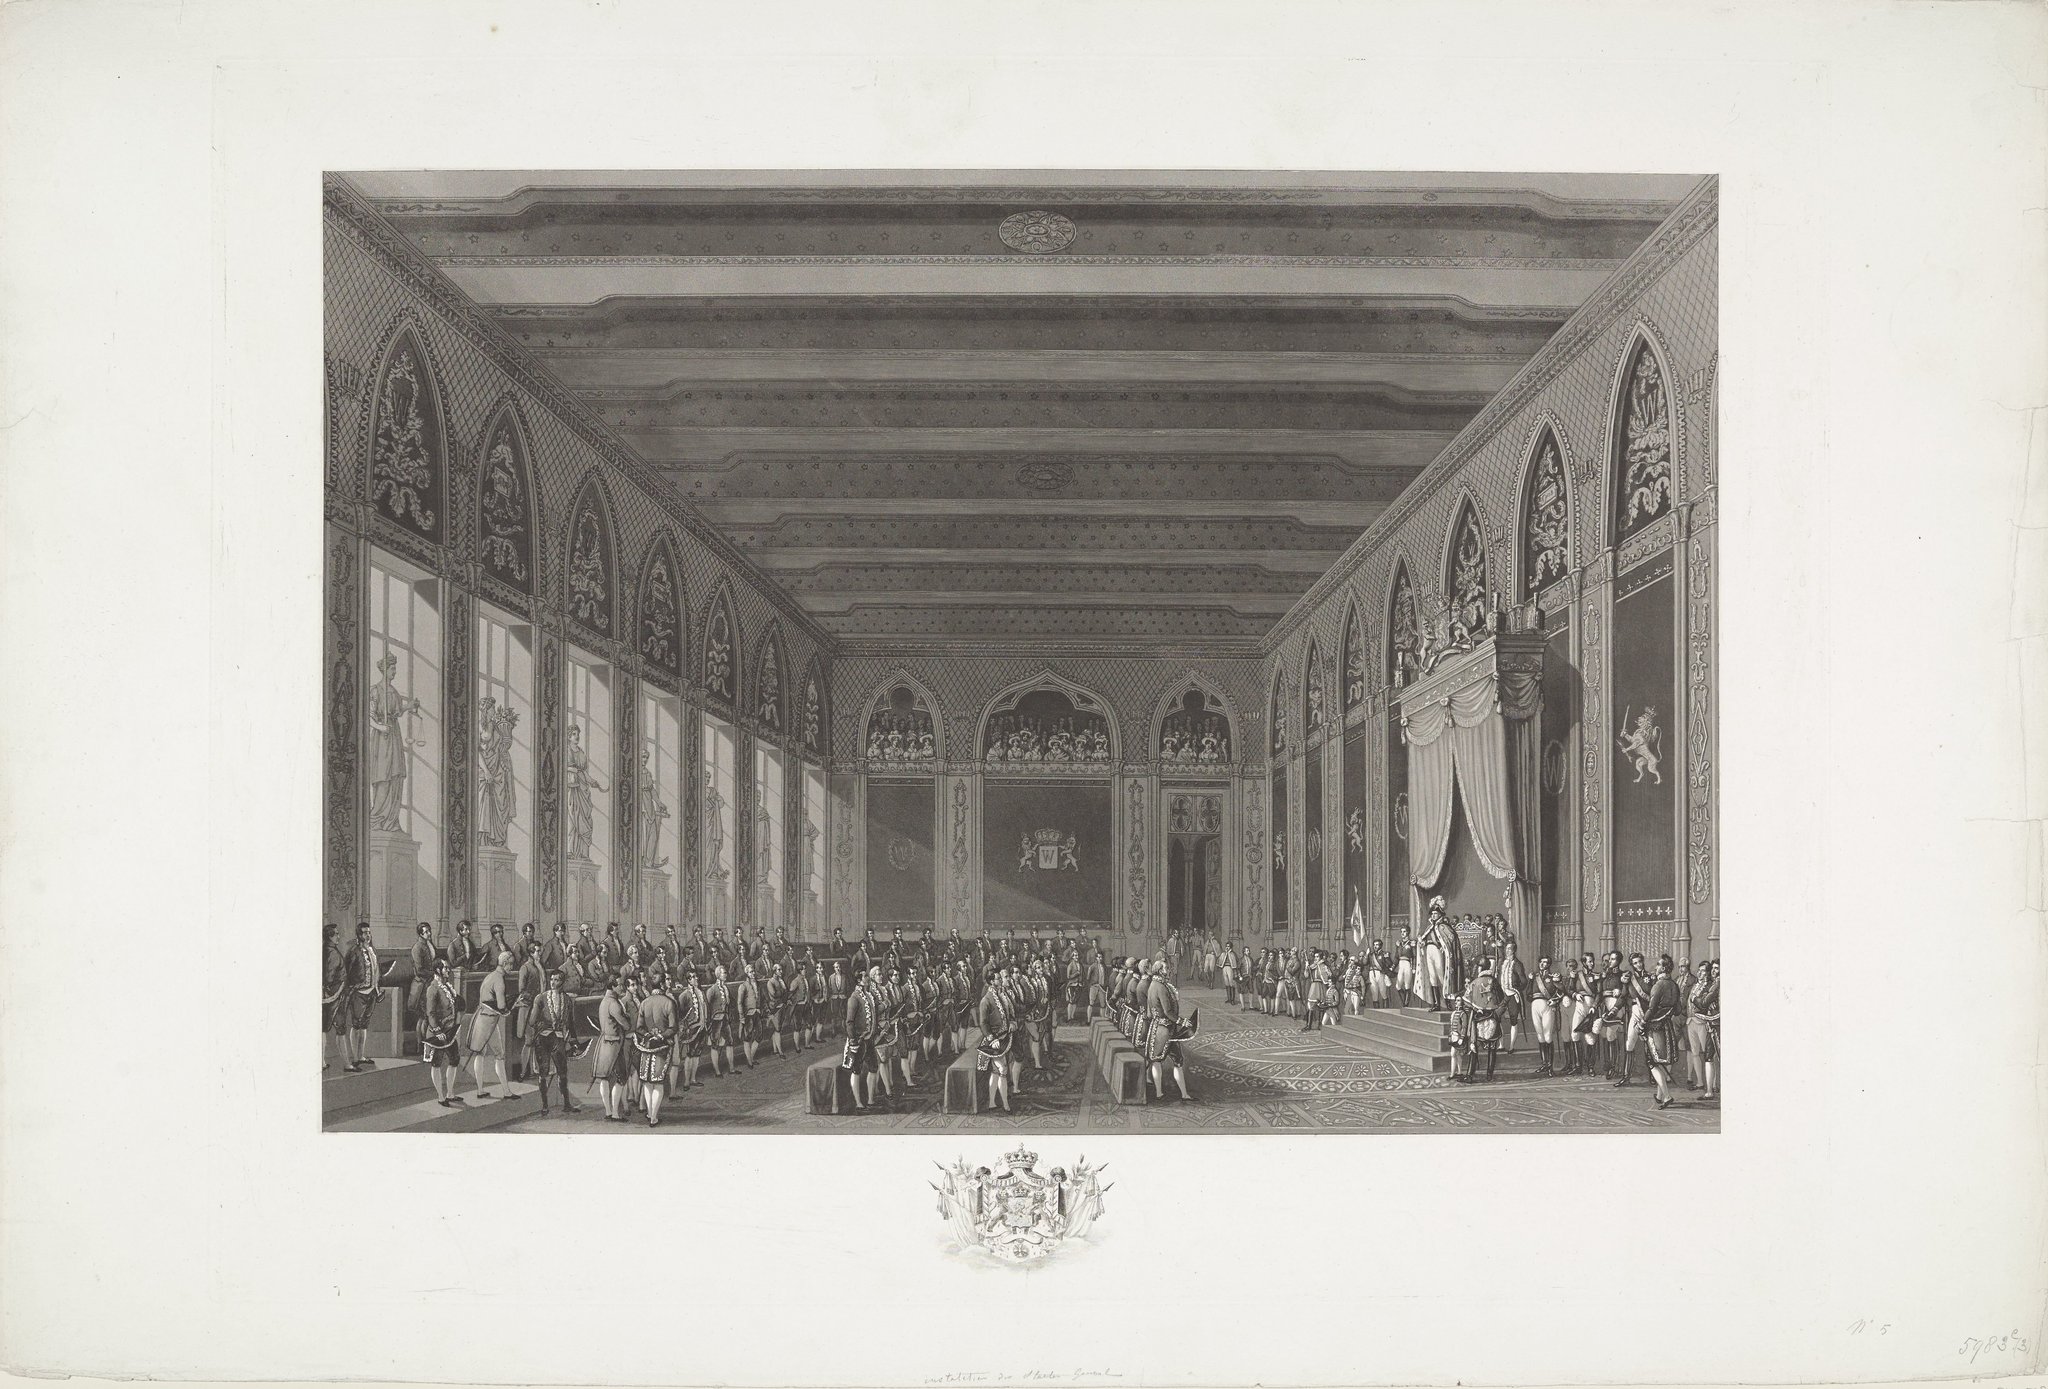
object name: print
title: Instelling van de Staten-Generaal door koning Willem I te Brussel op 21 september 1815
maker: johann nepomuk gibèle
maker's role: print maker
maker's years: 1775-1836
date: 1825-1826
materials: paper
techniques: aquatint, etching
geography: brussels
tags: the hague, berlin, william i of the netherlands, ceremonial celebration of installation of a ruler, popular representation ~ government, brussels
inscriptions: collector's mark: Lugt 2165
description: Instelling van de Staten-Generaal door koning Willem I te Brussel op 21 september 1815. Onderaan het wapen van koning Willem I. Onderdeel van een serie platen van de aankomst en inhuldiging van Willem I in Brussel.